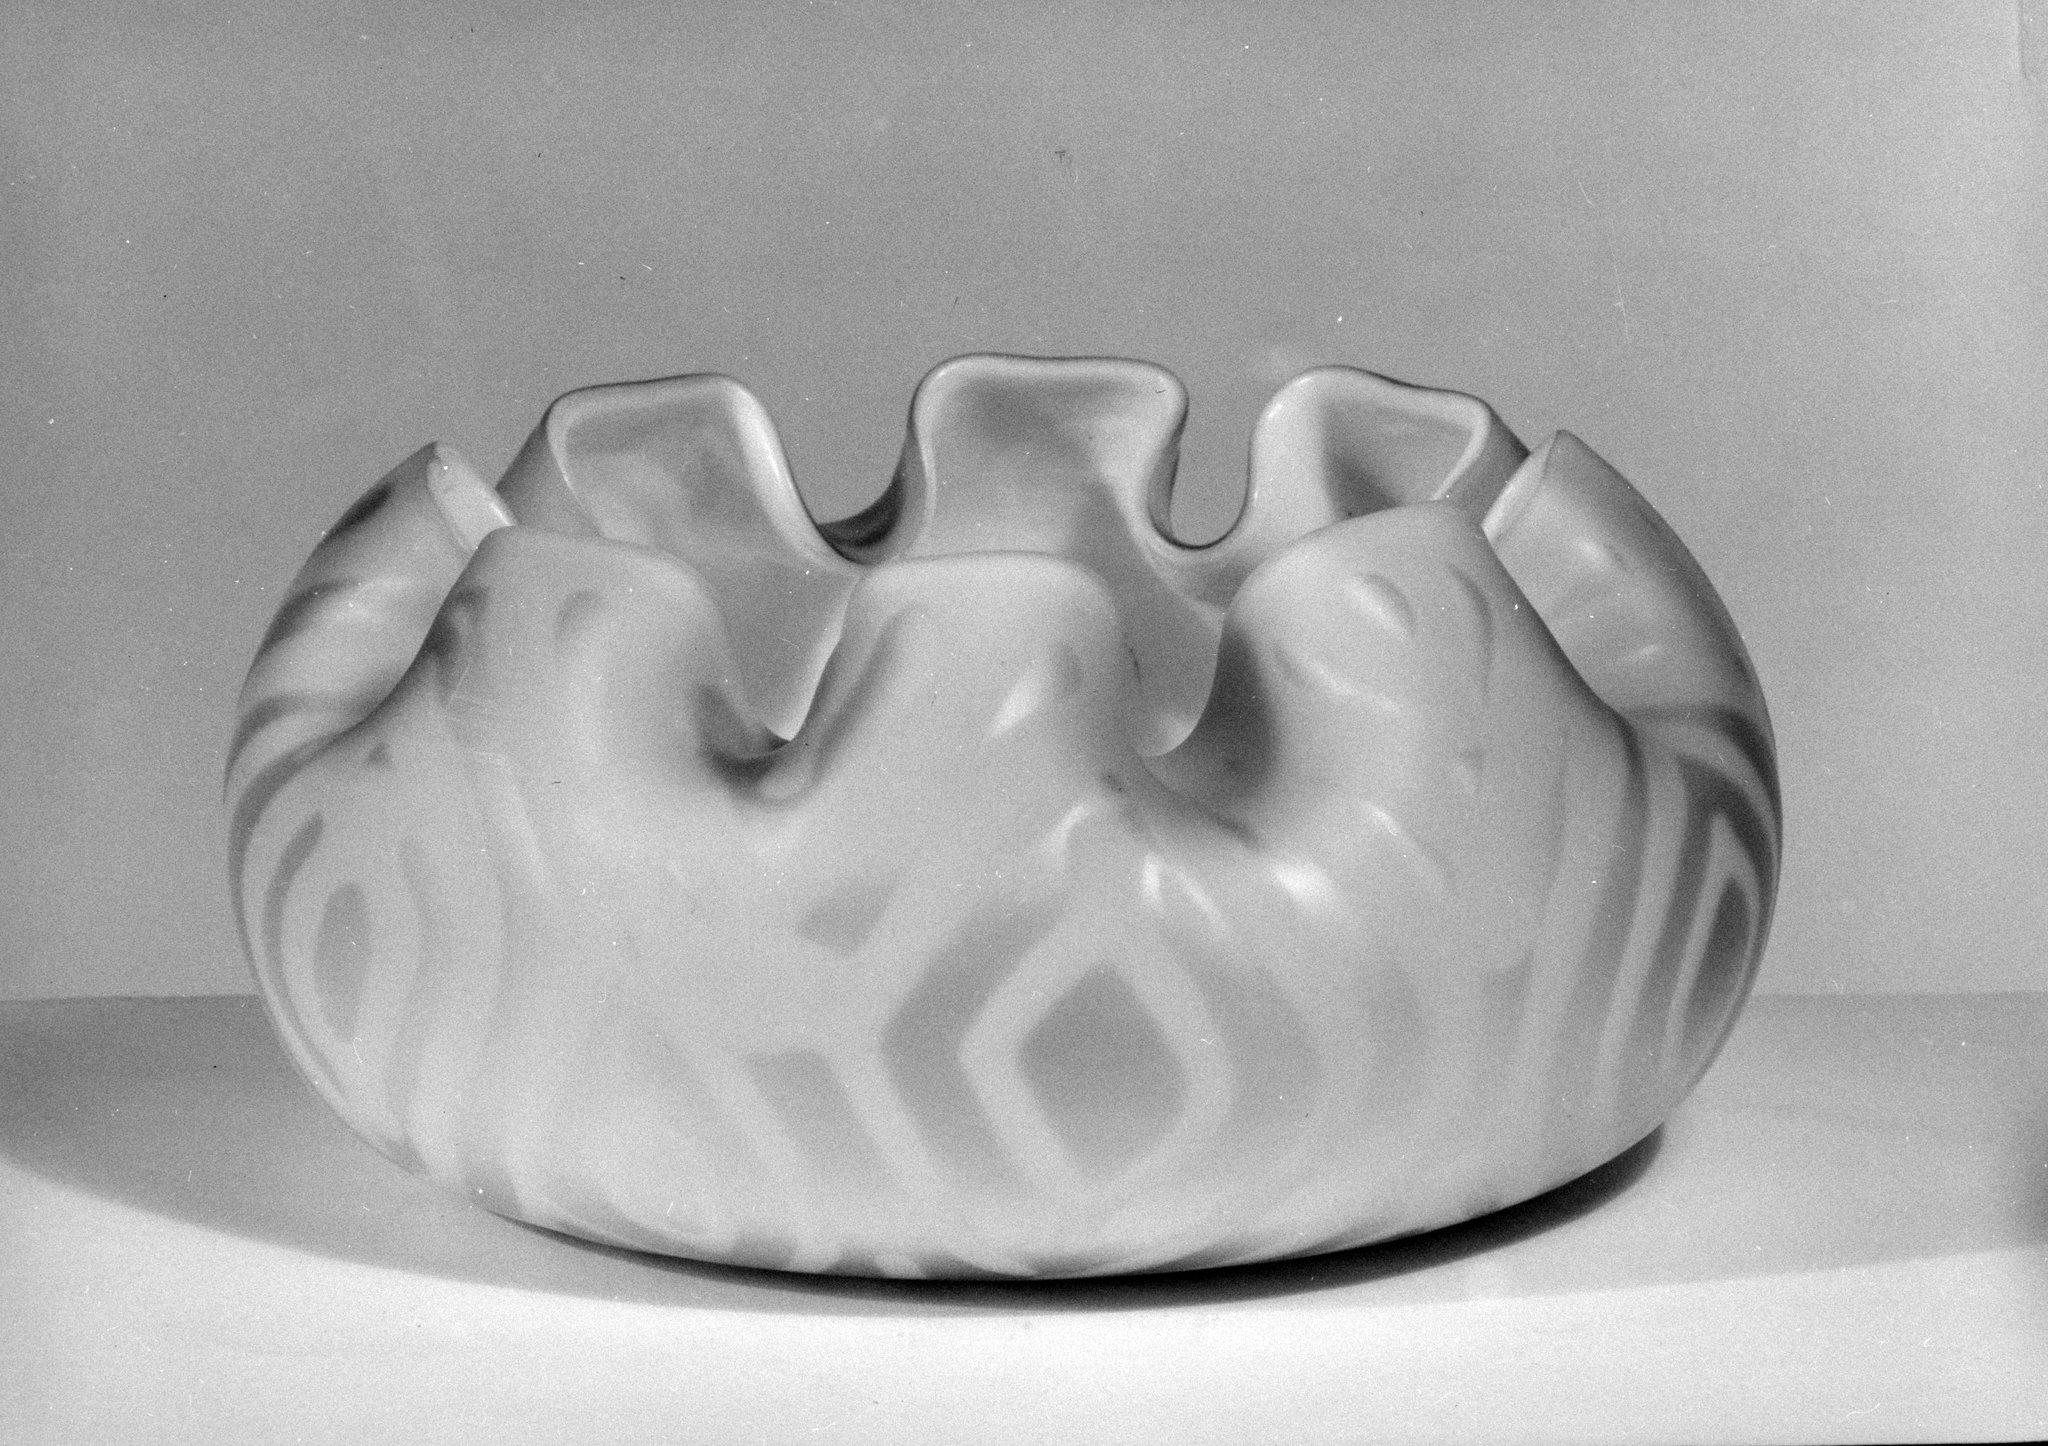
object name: bowl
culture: american or british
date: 1885-1900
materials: glass, textile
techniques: glassblowing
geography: england